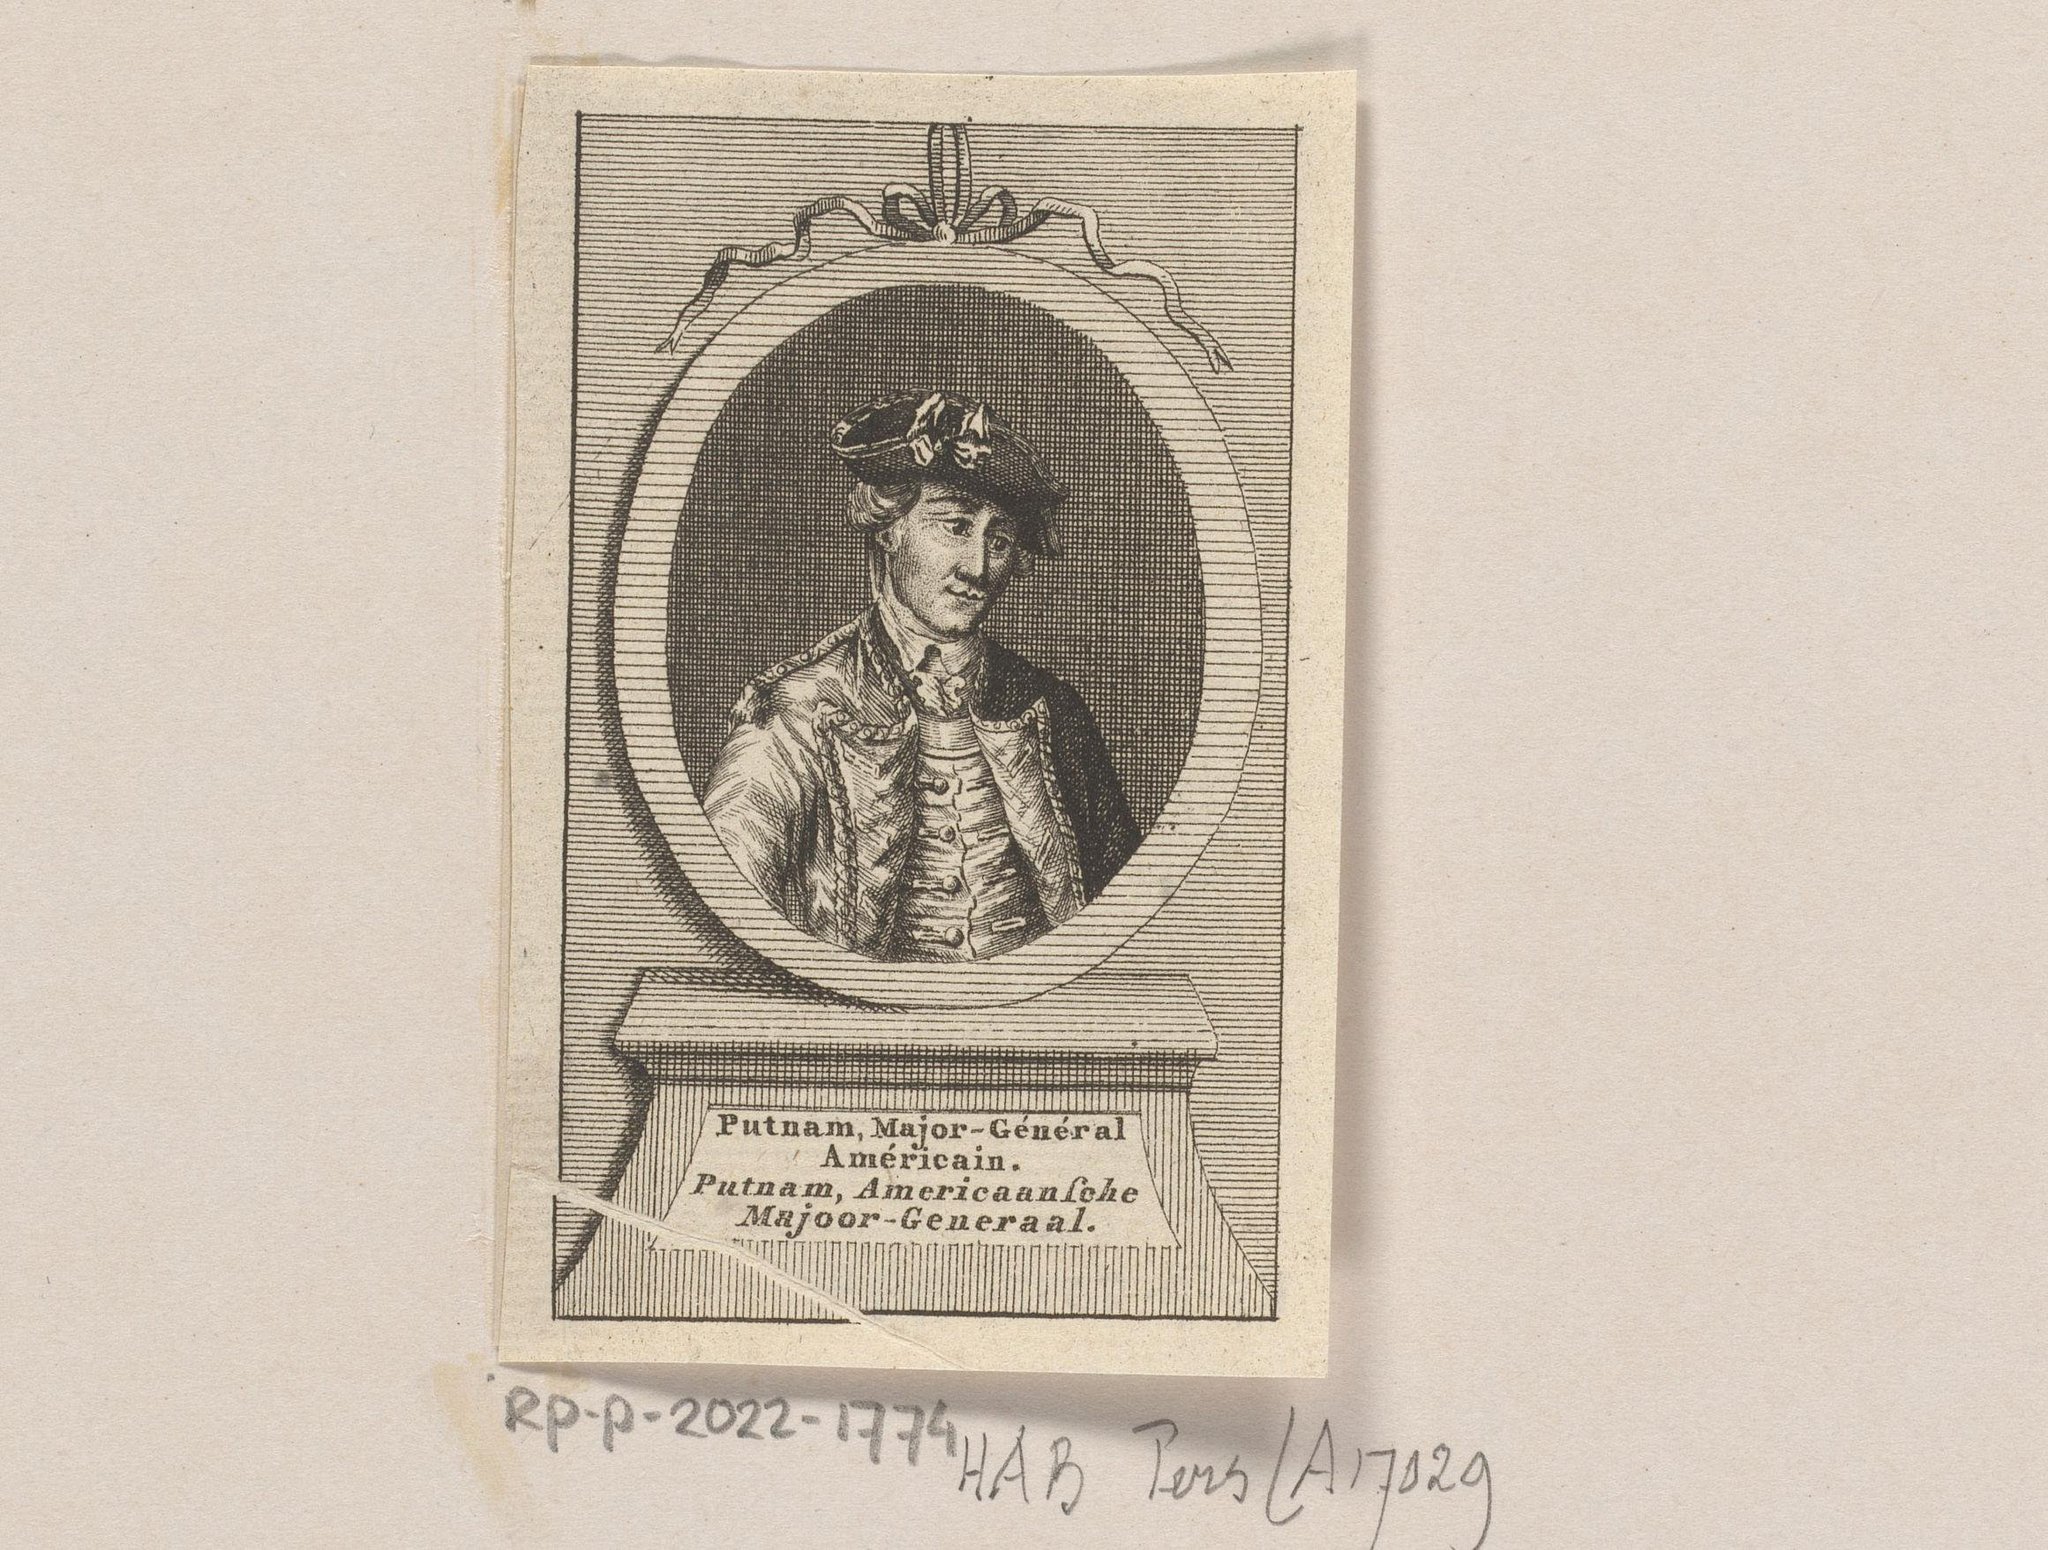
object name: print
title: Portret van Israel Putnam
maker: Anonymous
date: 1775-1799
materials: paper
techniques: etching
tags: commander-in-chief, general, marshal, historical persons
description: Met vierregelig onderschrift in het Frans en Nederlands.